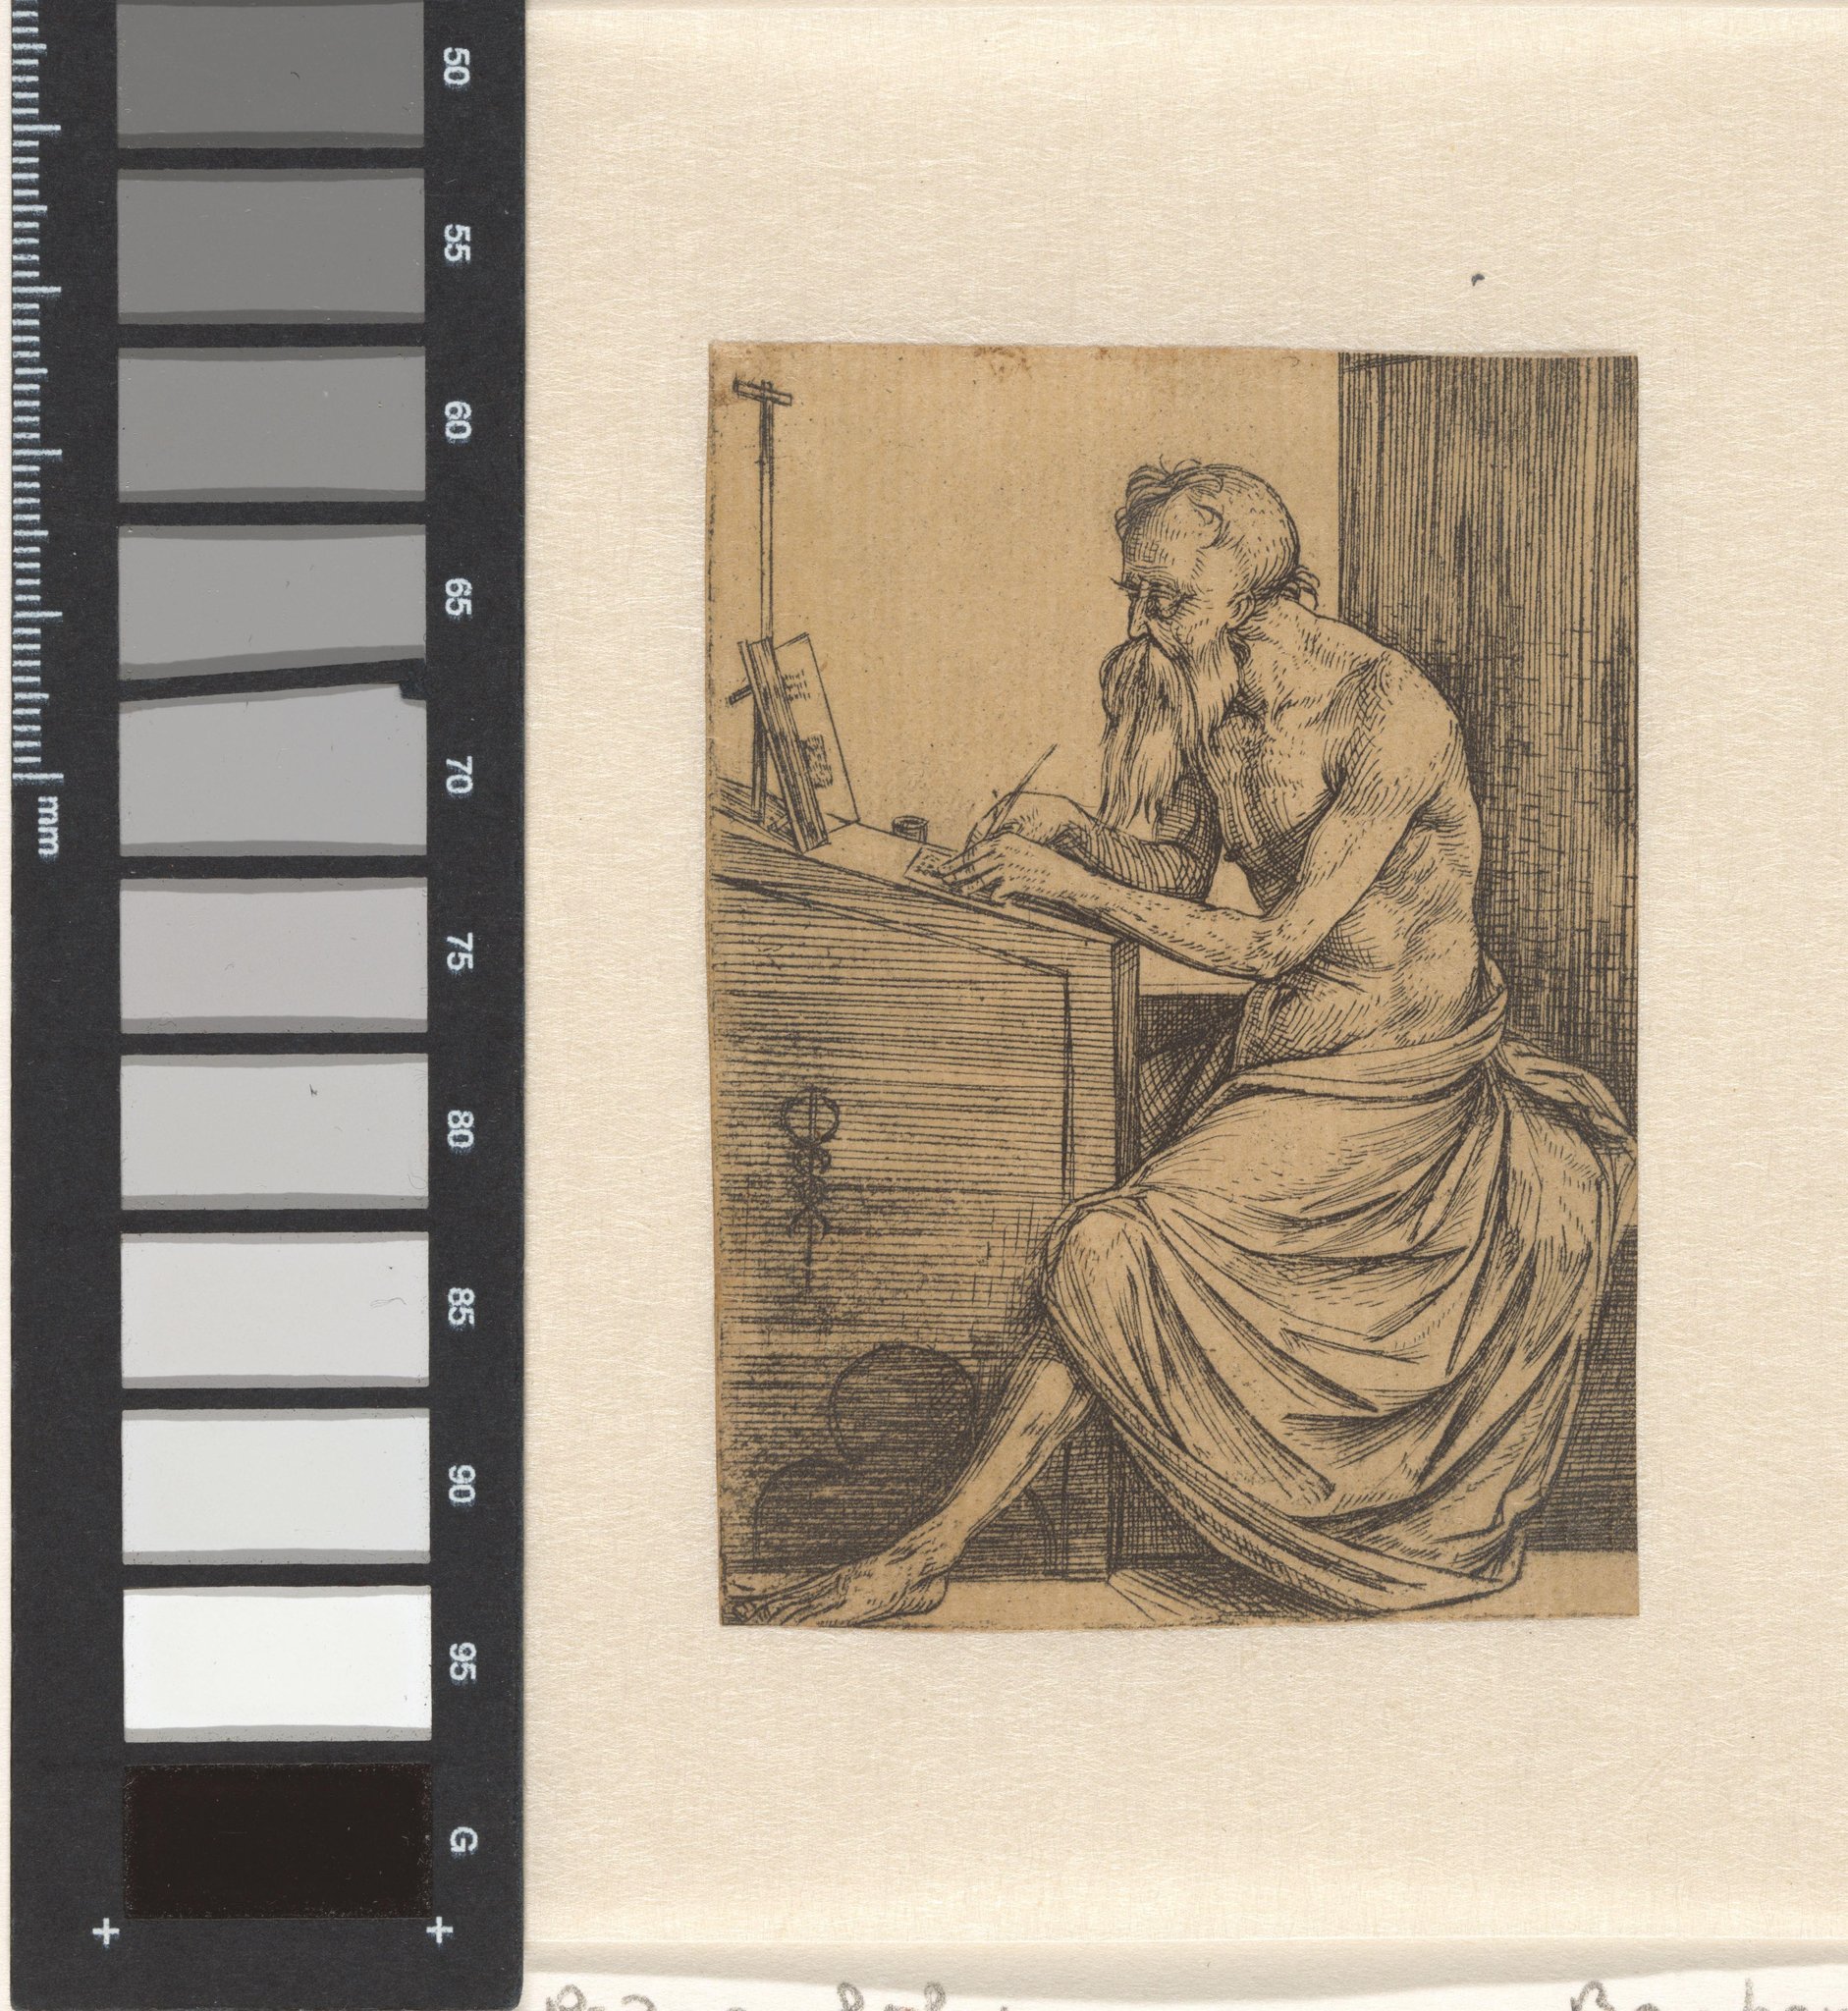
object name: print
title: Heilige Hieronymus in zijn studeervertrek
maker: jacopo de barbari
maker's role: draughtsman, print maker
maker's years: 1440-1516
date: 1495-1516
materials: paper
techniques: engraving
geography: venice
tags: st. jerome as penitent in his study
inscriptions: collector's mark: Lugt 2228, collector's mark: Lugt 2760